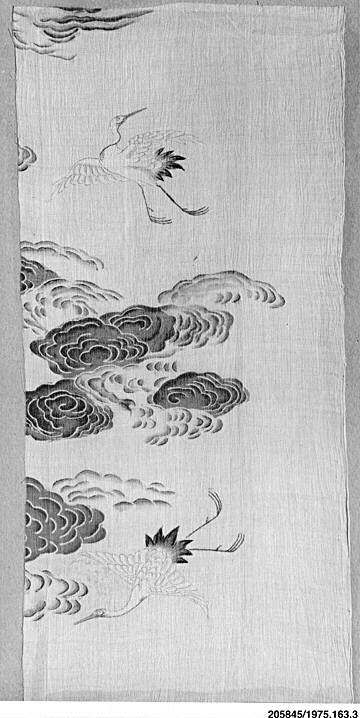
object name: piece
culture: japanese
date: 1868-1912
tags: birds,clouds